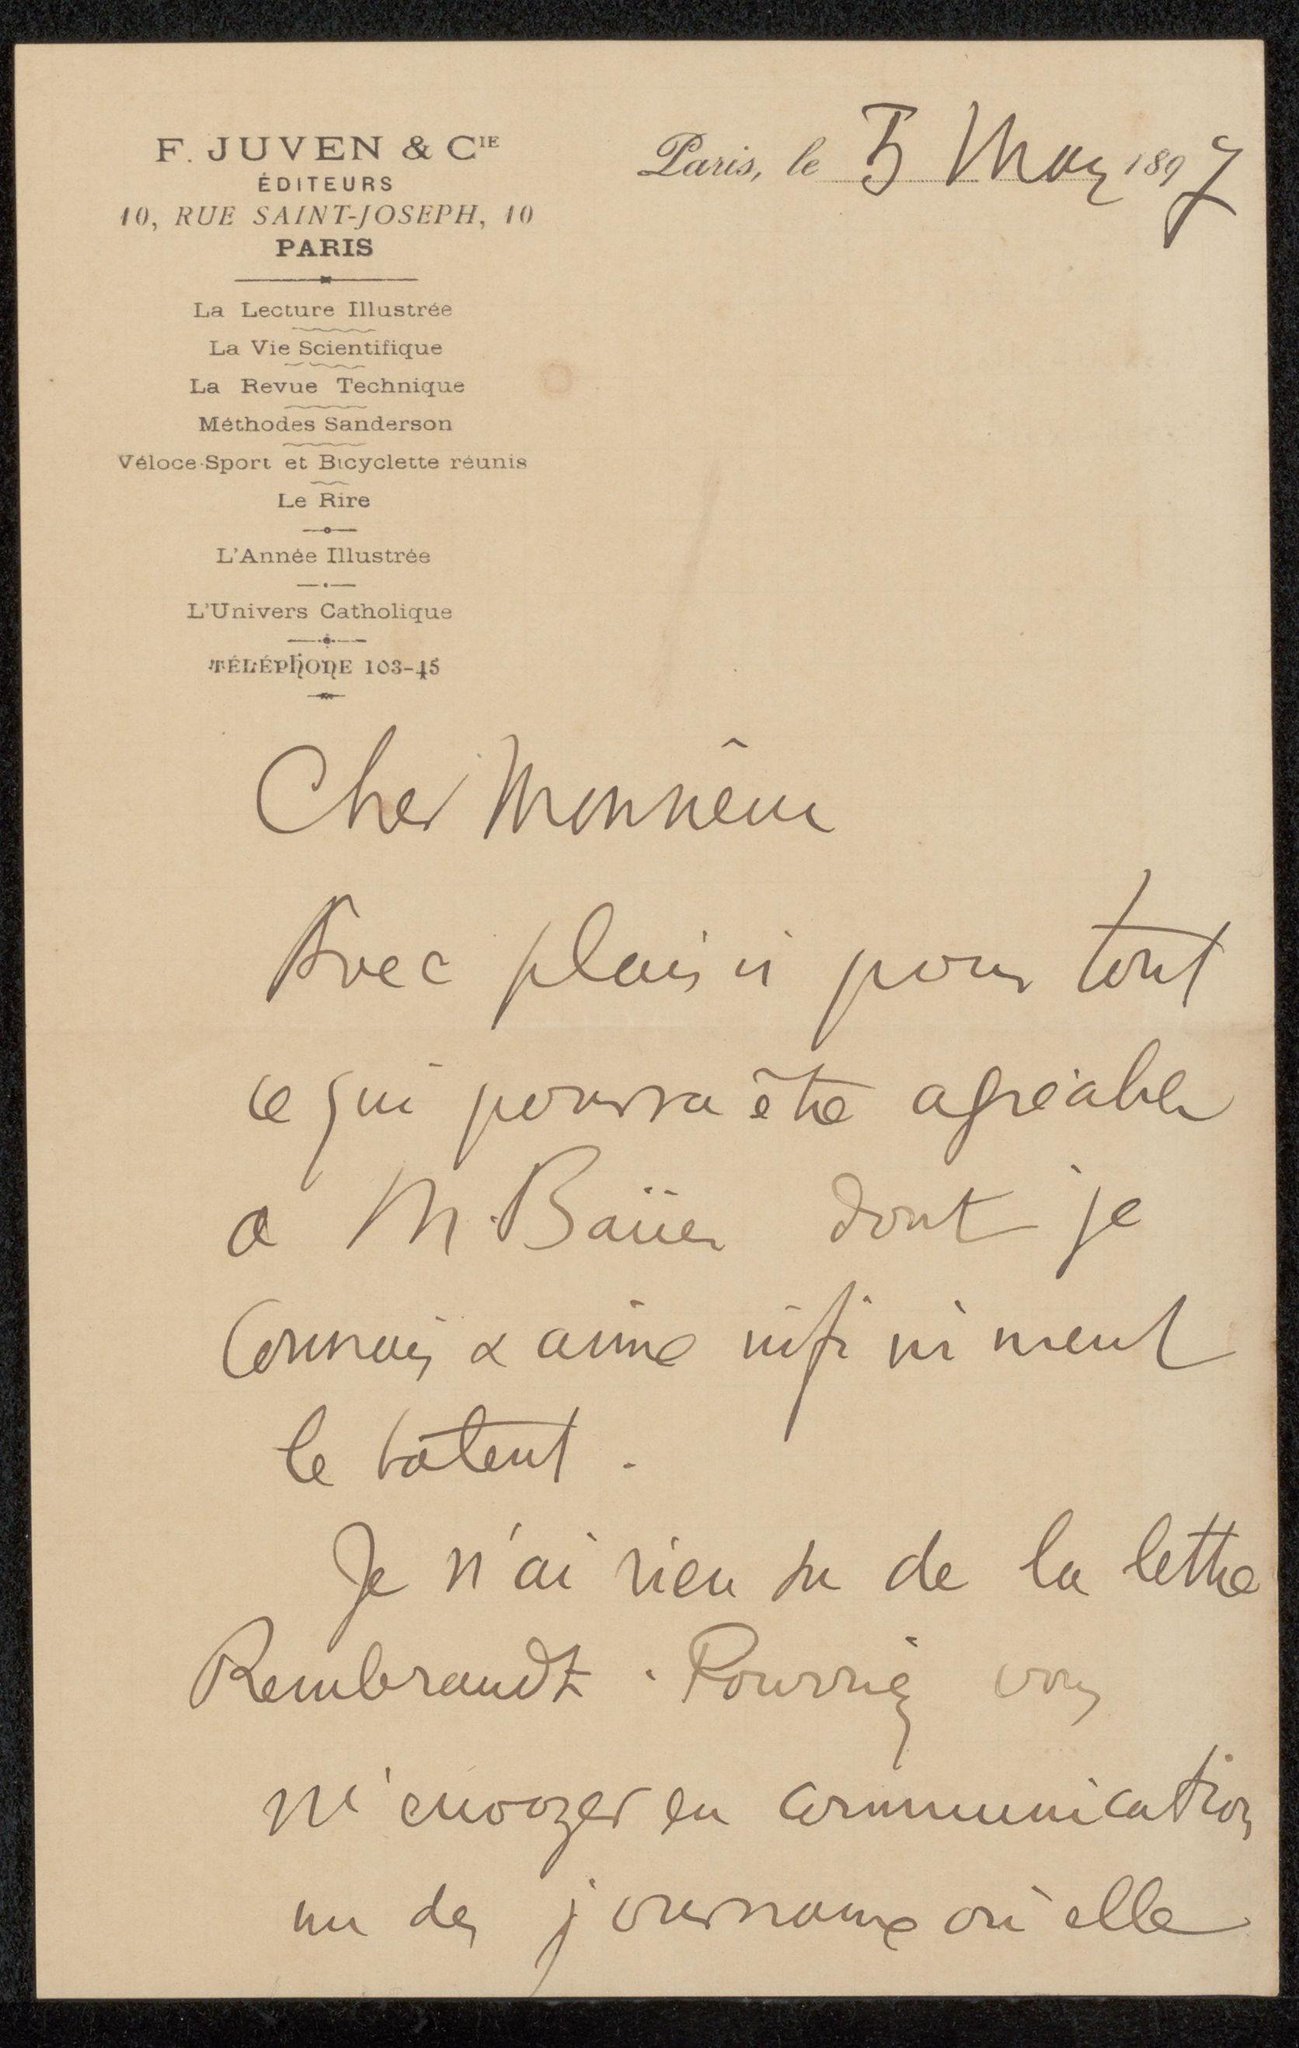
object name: letter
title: Brief aan Philip Zilcken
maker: arsène alexandre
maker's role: auteur, verzamelaar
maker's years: 1859-1937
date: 1897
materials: ink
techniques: pen, printing, writing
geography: paris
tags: marius bauer, leiden, amsterdam, print maker, rembrandt van rijn, publisher, the hague, painter, draughtsman, philip zilcken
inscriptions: collector's mark: ‘RPK’